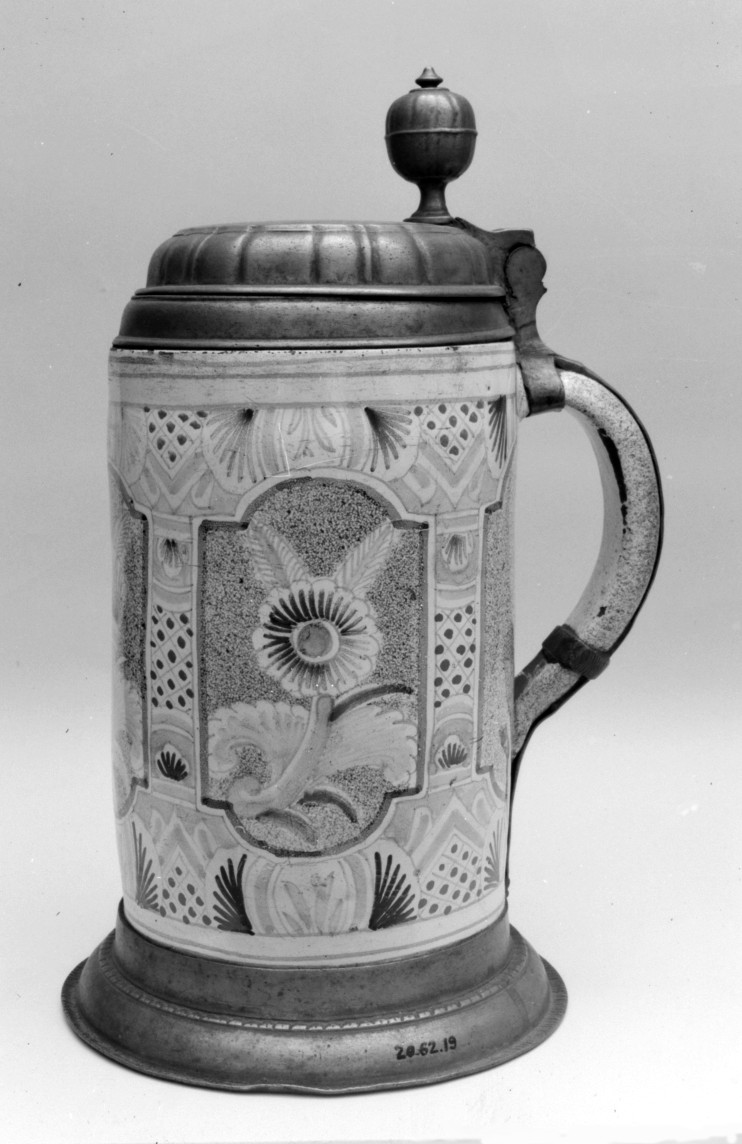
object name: tankard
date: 1701-1800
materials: earthenware, pewter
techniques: glazing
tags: flowers